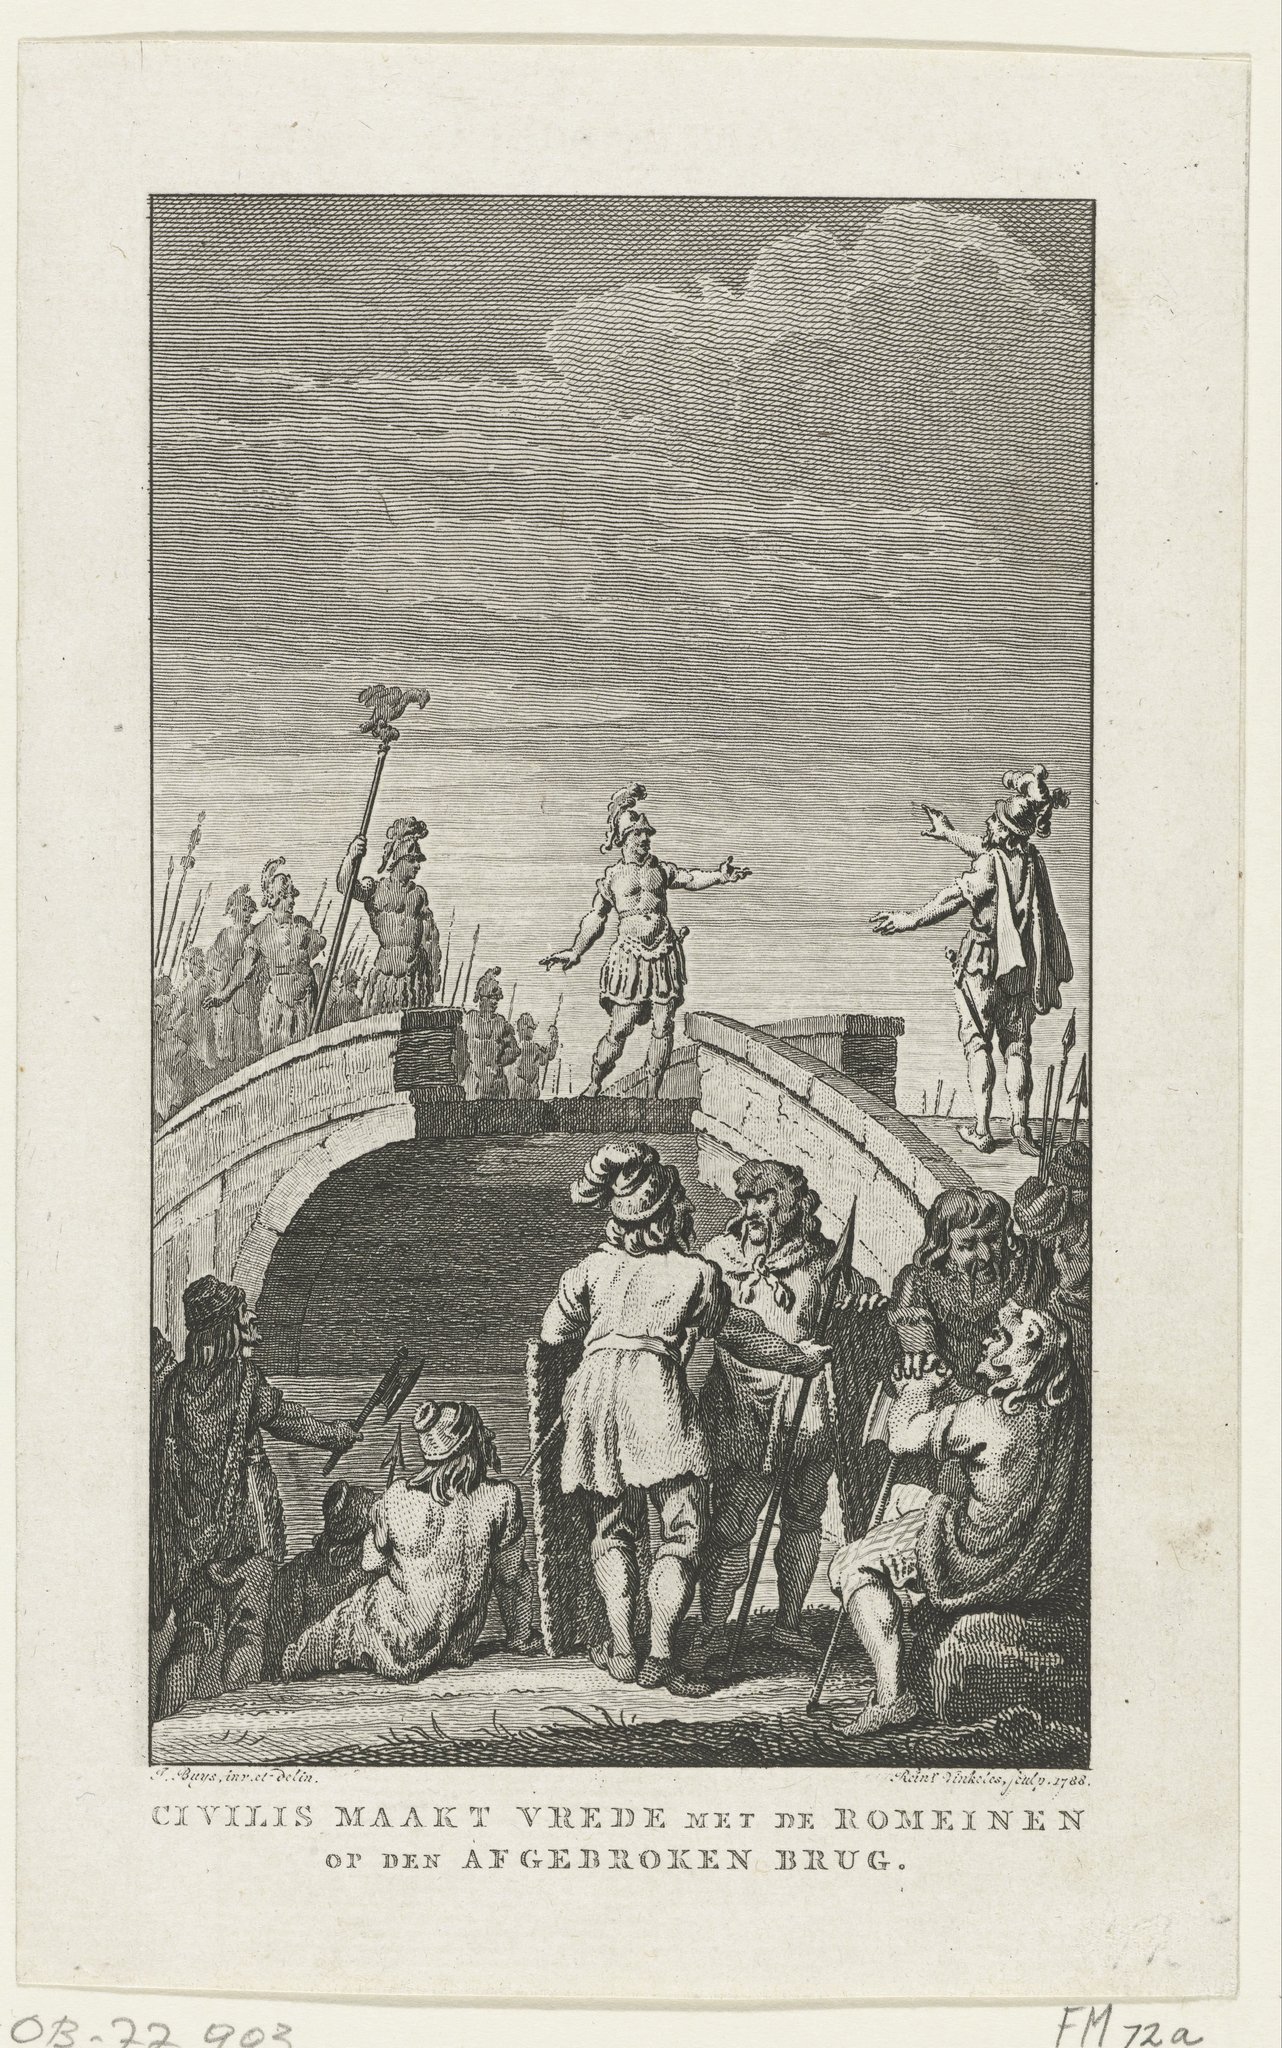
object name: history print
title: Civilis en Cerialis onderhandelen op de afgebroken brug, 69-70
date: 1788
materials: paper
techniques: etching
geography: netherlands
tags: peace negotiations, extinct, 'historical' peoples (with name), netherlands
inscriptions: date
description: Illustratie voor: Jacobus Kok, Vaderlandsch Woordenboek, Johannes Allart, Amsterdam 1785-1799, 35 delen, dl. IX, pl. IV. Staat met de letter.